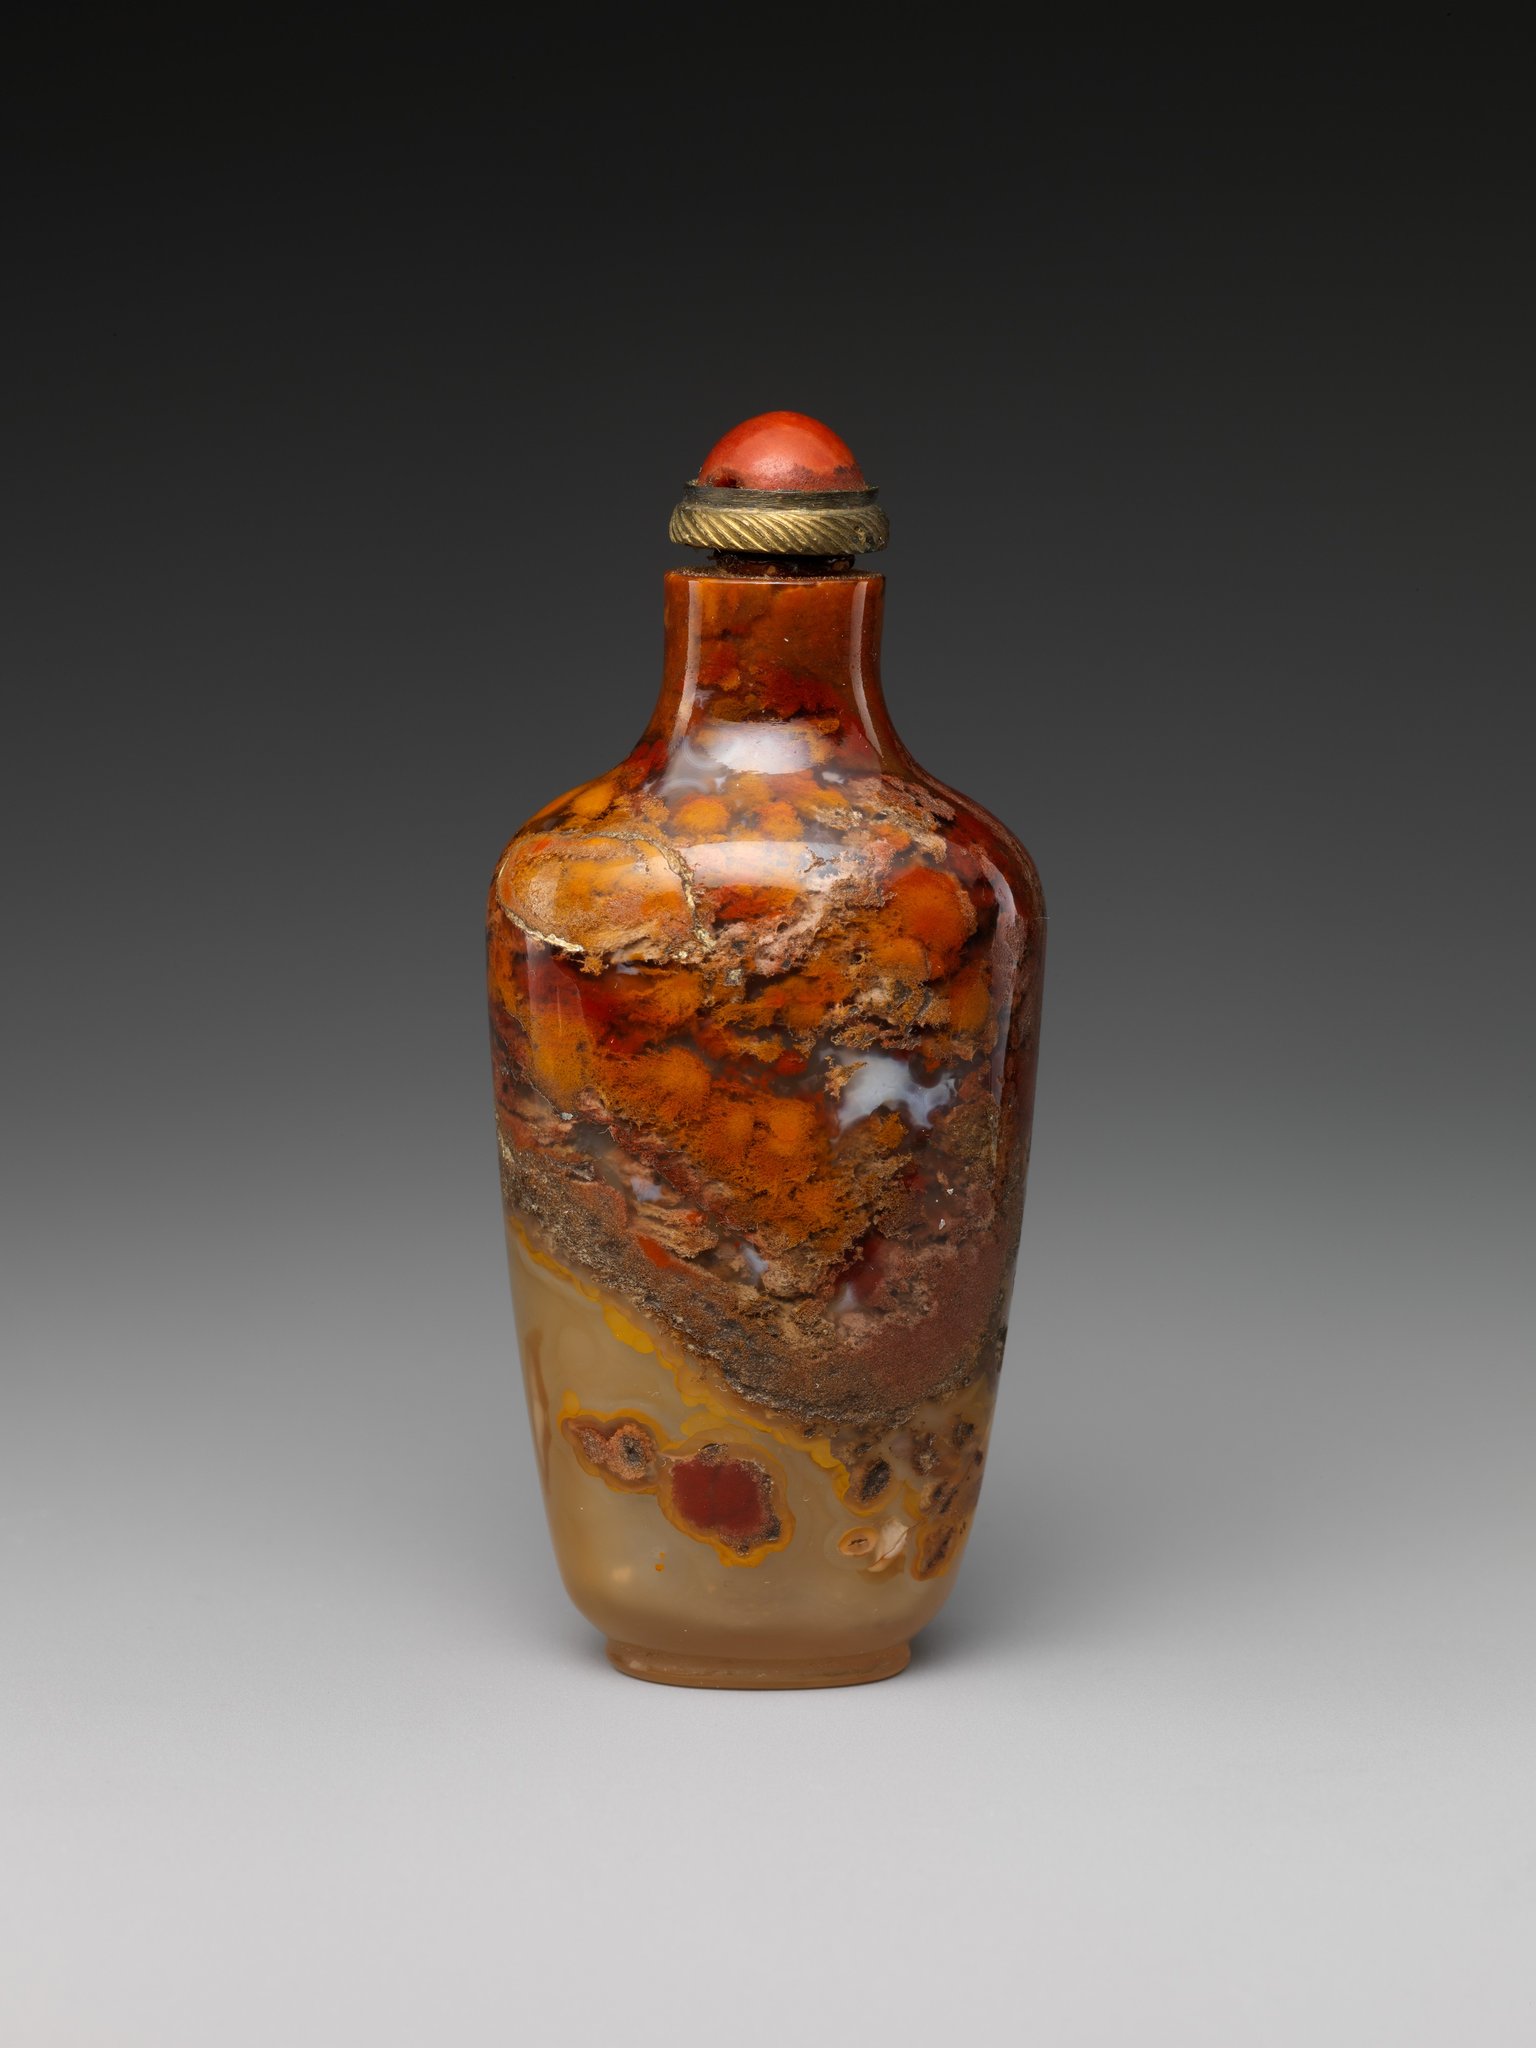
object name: snuff bottle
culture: chinese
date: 1801-1900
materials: stone, jasper